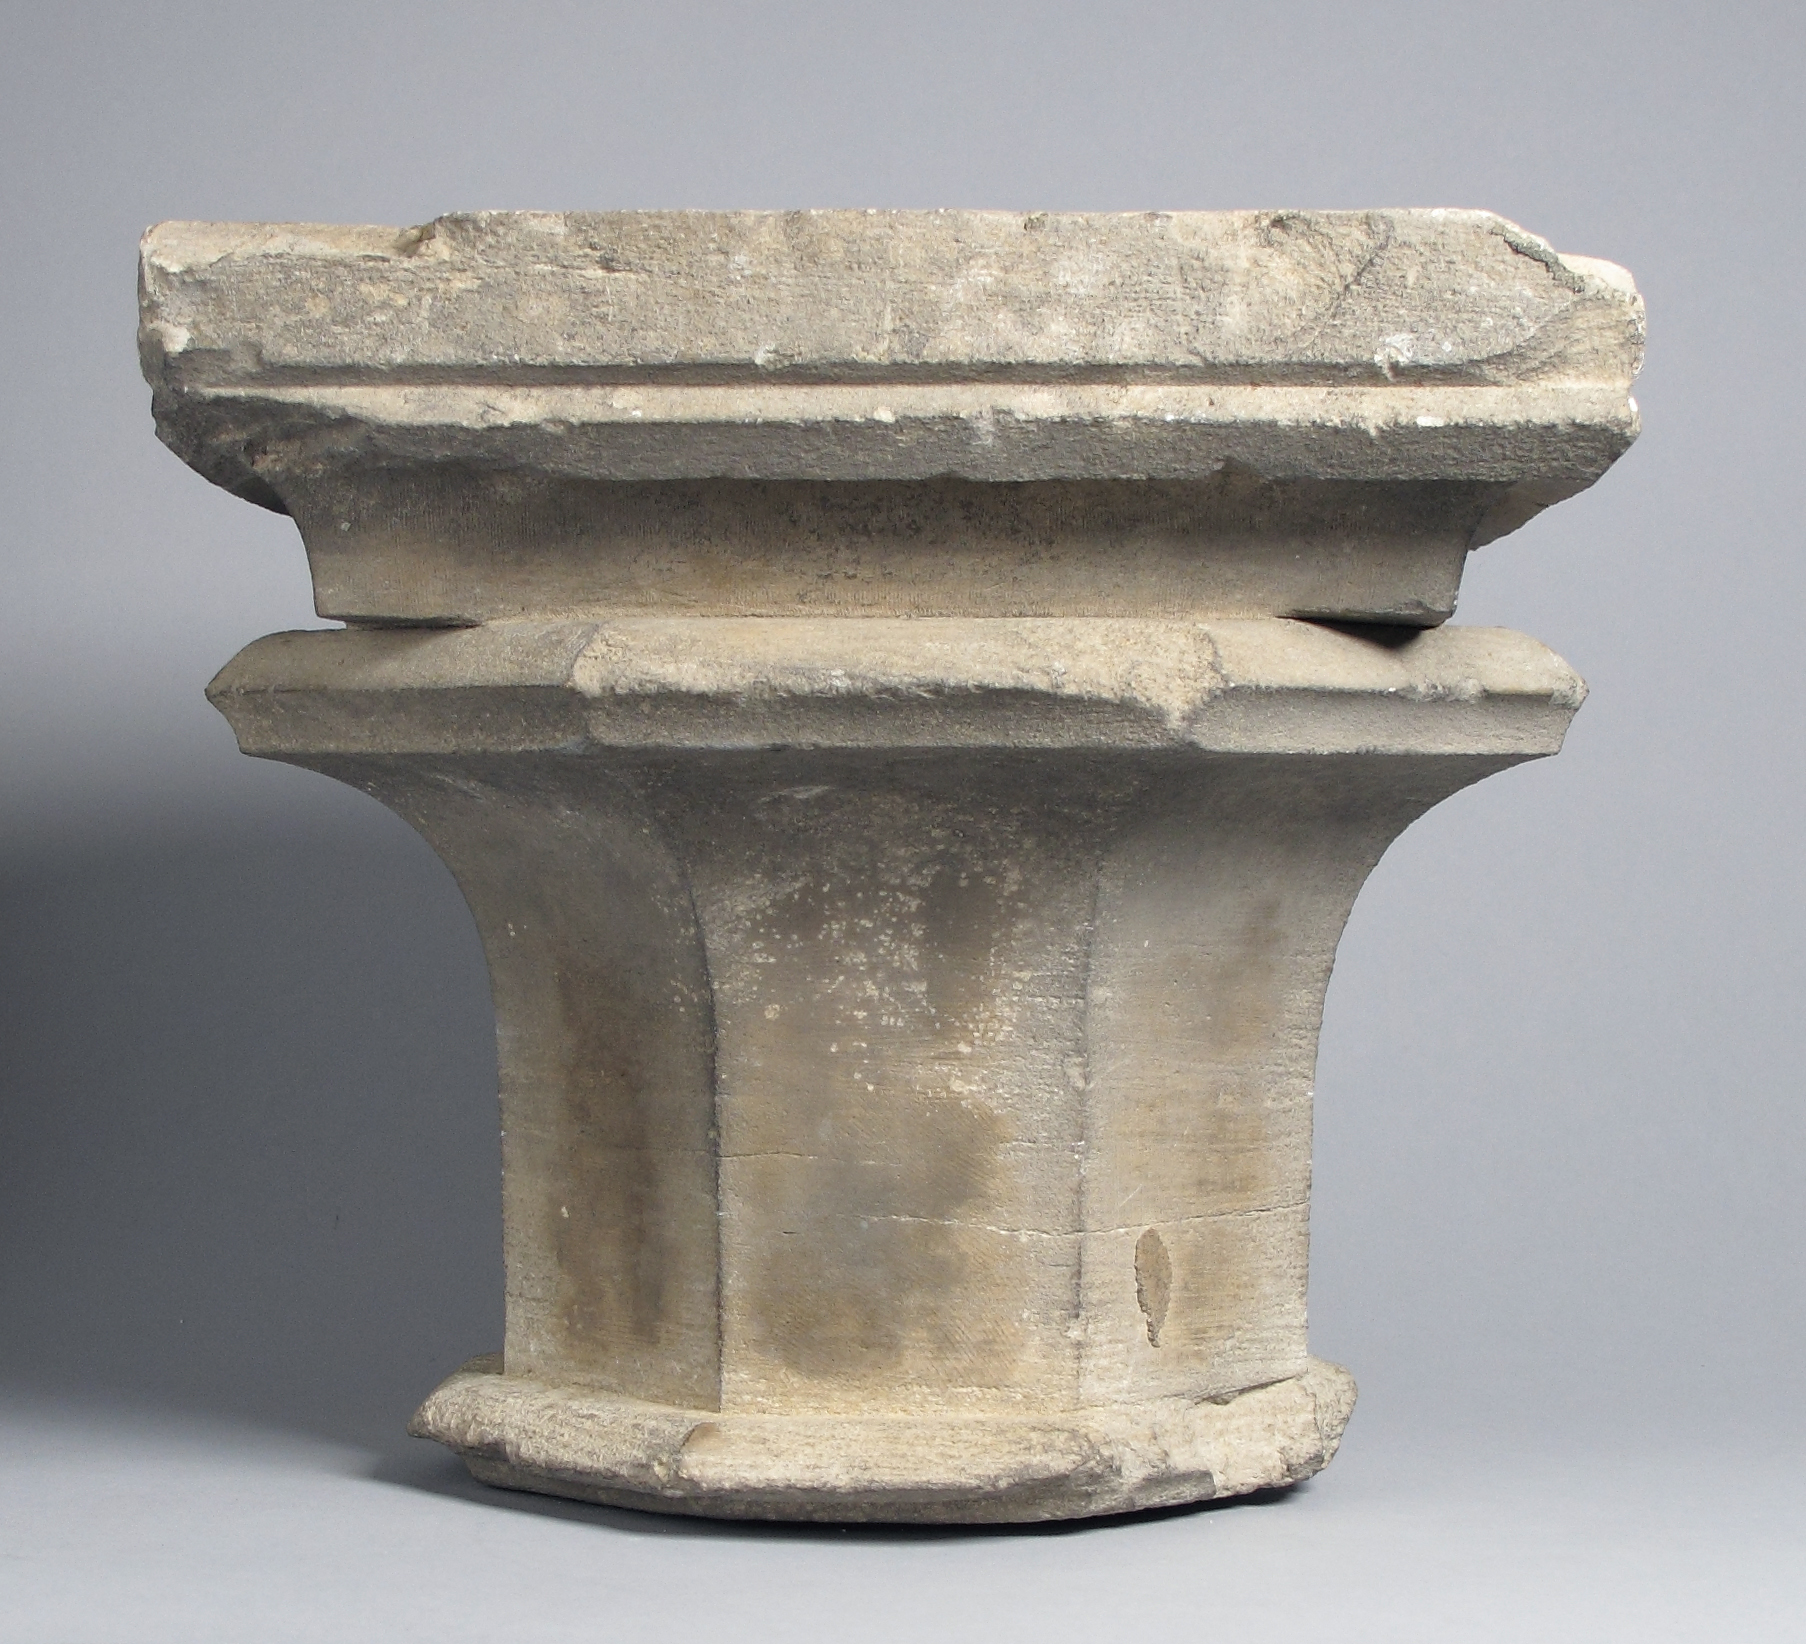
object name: base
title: Column Base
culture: french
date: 1167-1200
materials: stone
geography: france